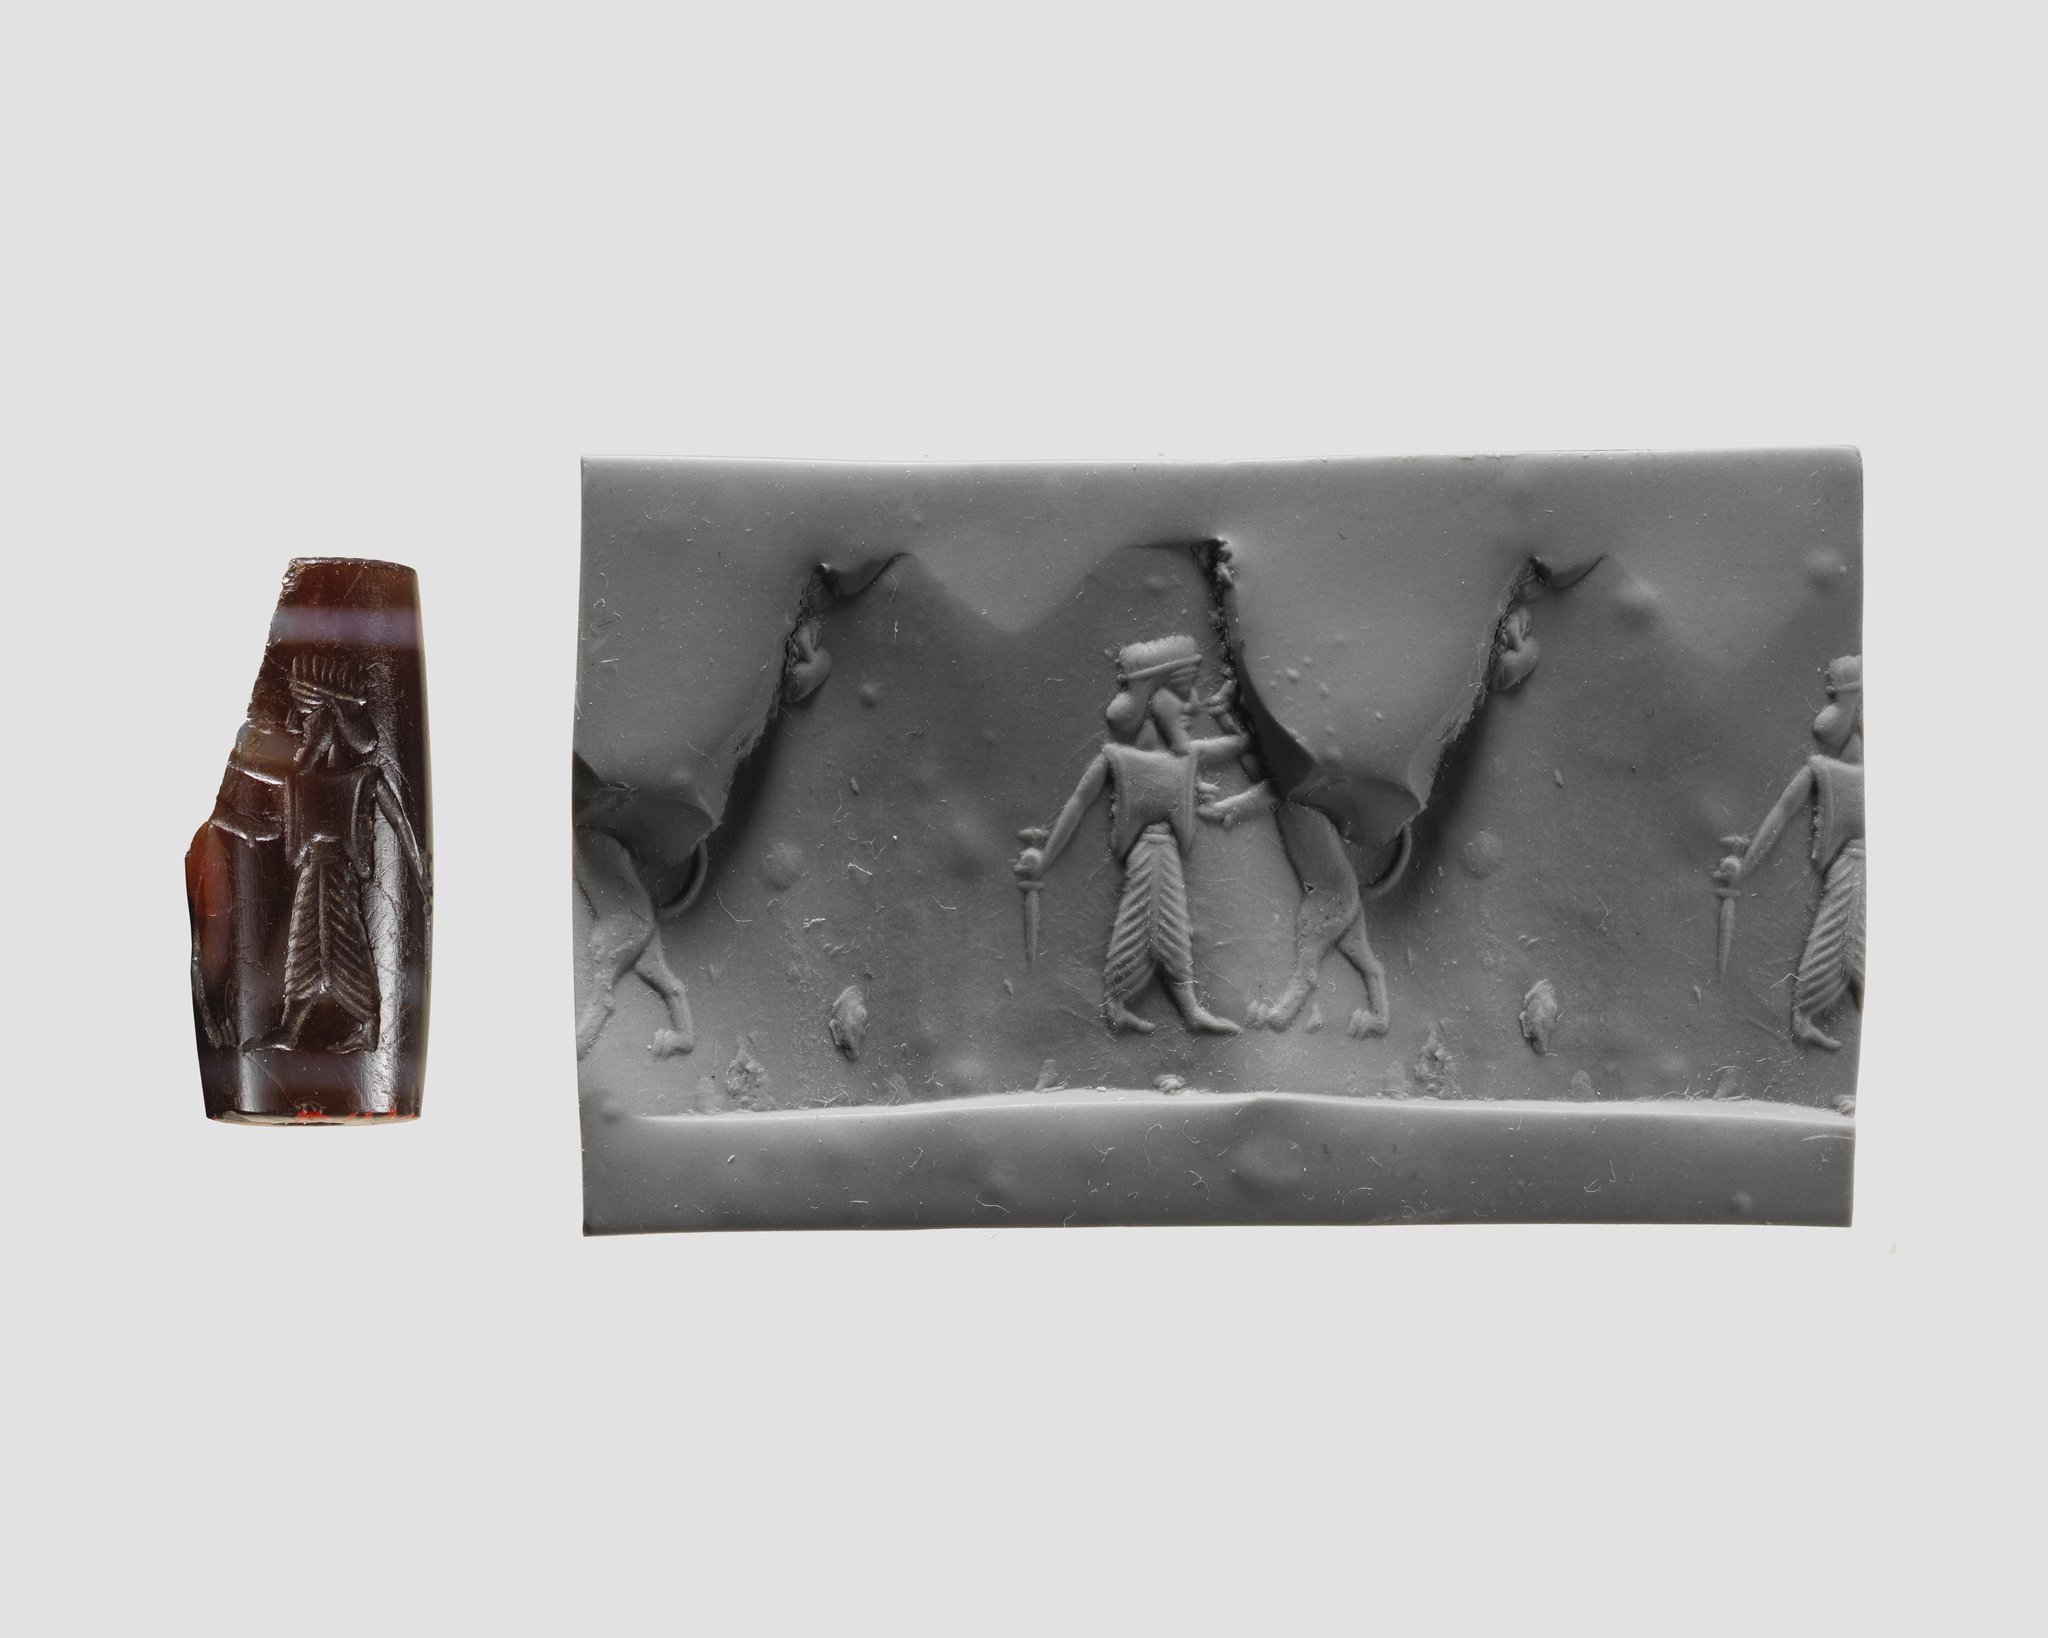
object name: cylinder seal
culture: achaemenid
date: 600-401 BCE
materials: stone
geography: iran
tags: men